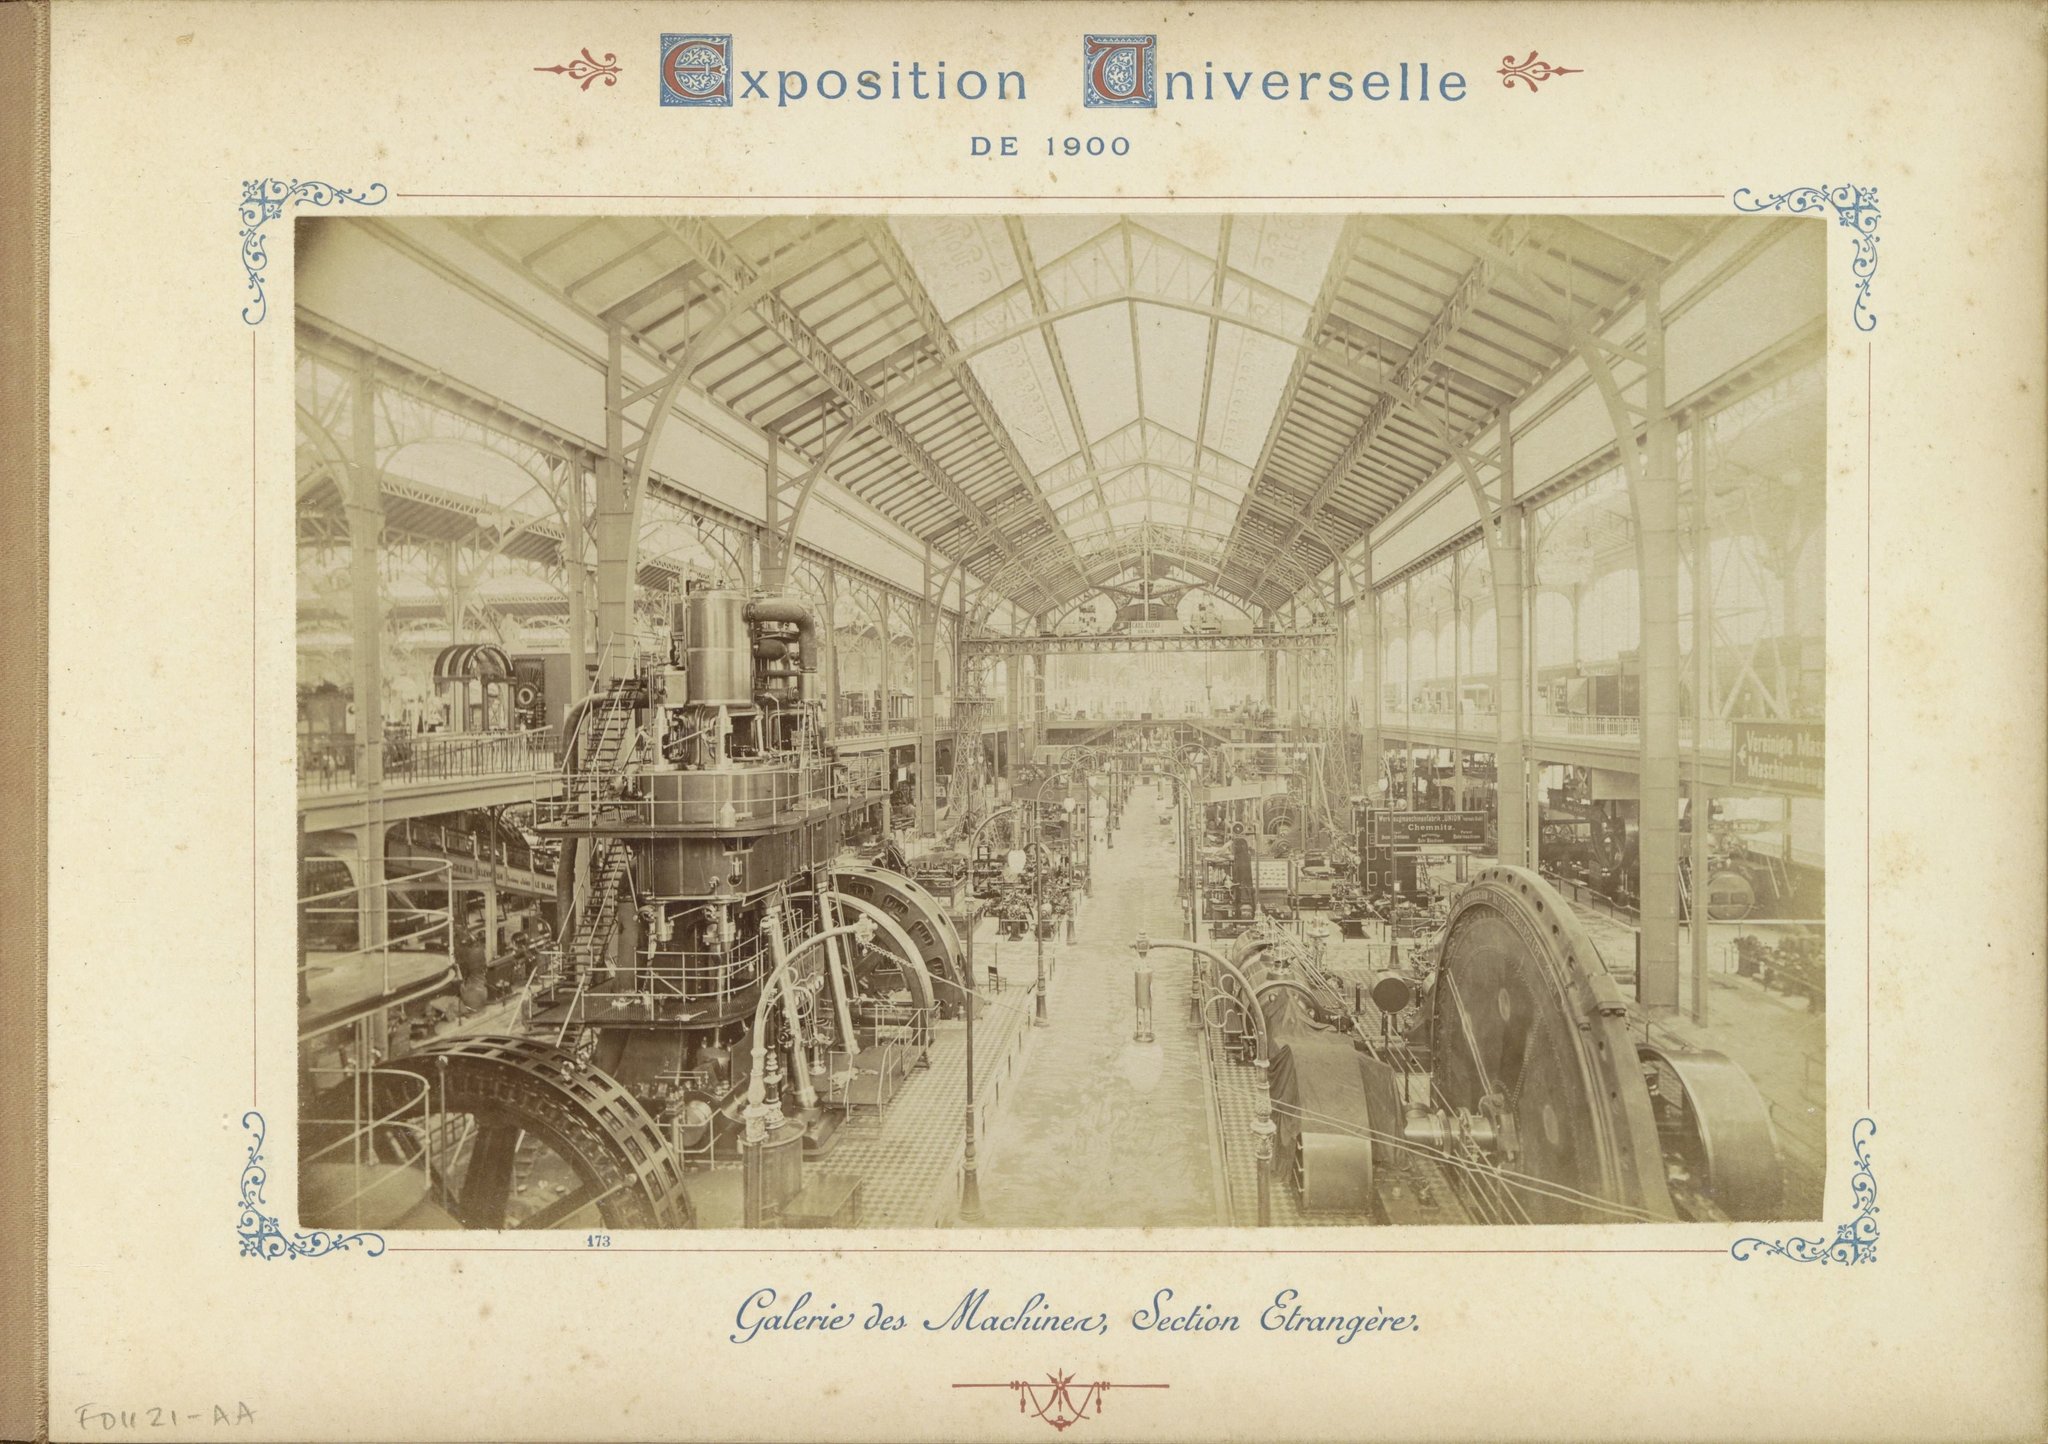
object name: photograph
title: Galerie des Machines, la Section Etrangère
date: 1900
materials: cardboard, paper, photographic support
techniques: albumen print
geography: paris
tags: world fair, world exhibition, machines, engines ~ crafts and industries, paris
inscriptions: number: ‘173’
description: Onderdeel van Fotoalbum met opnames van de Wereldtentoonstelling van 1900 in Parijs.